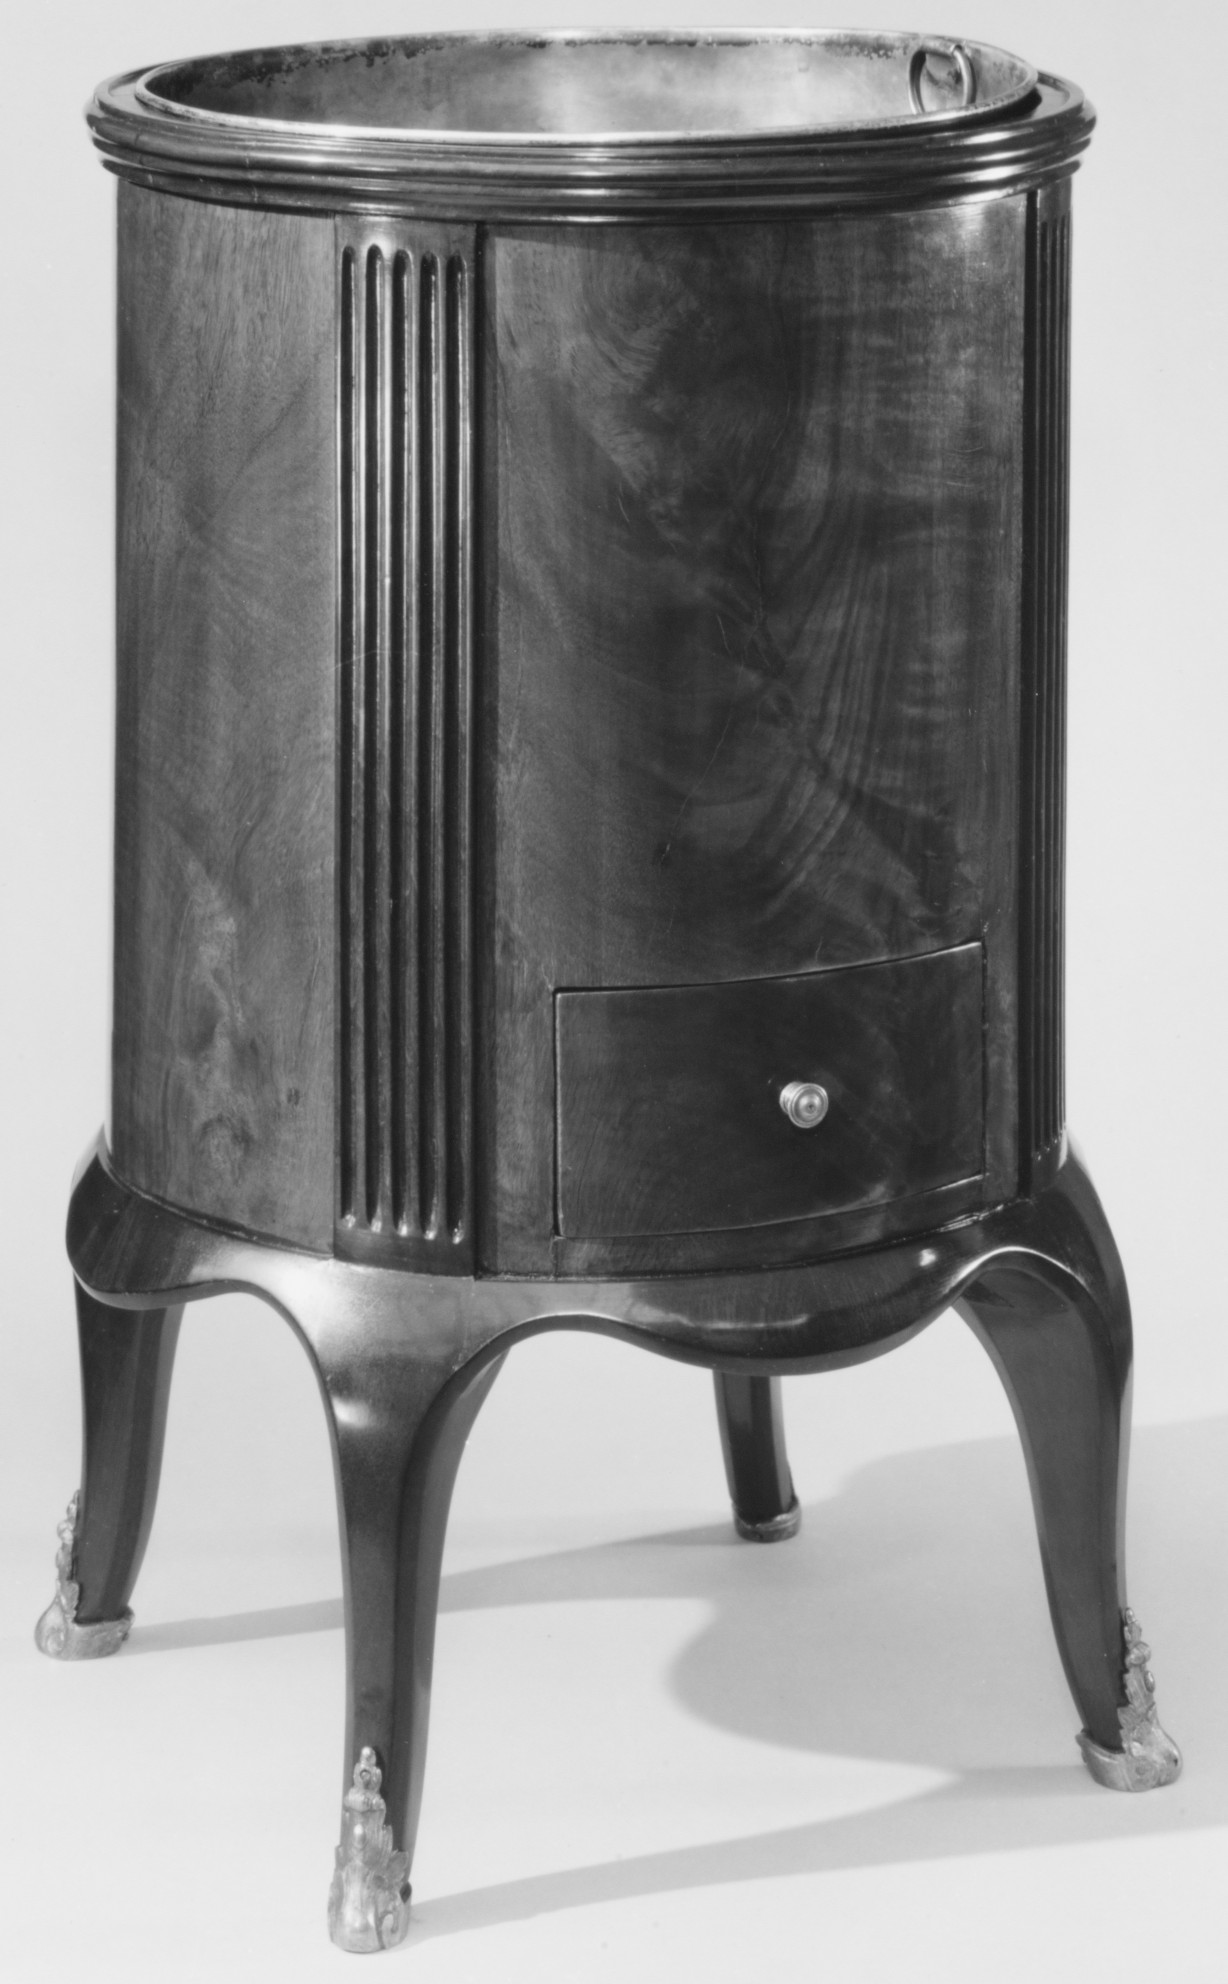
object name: wine cooler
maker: joseph gegenbach, called canabas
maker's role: maker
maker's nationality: french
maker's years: 1715-1797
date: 1780-1790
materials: copper, gilt bronze, wood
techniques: veneering